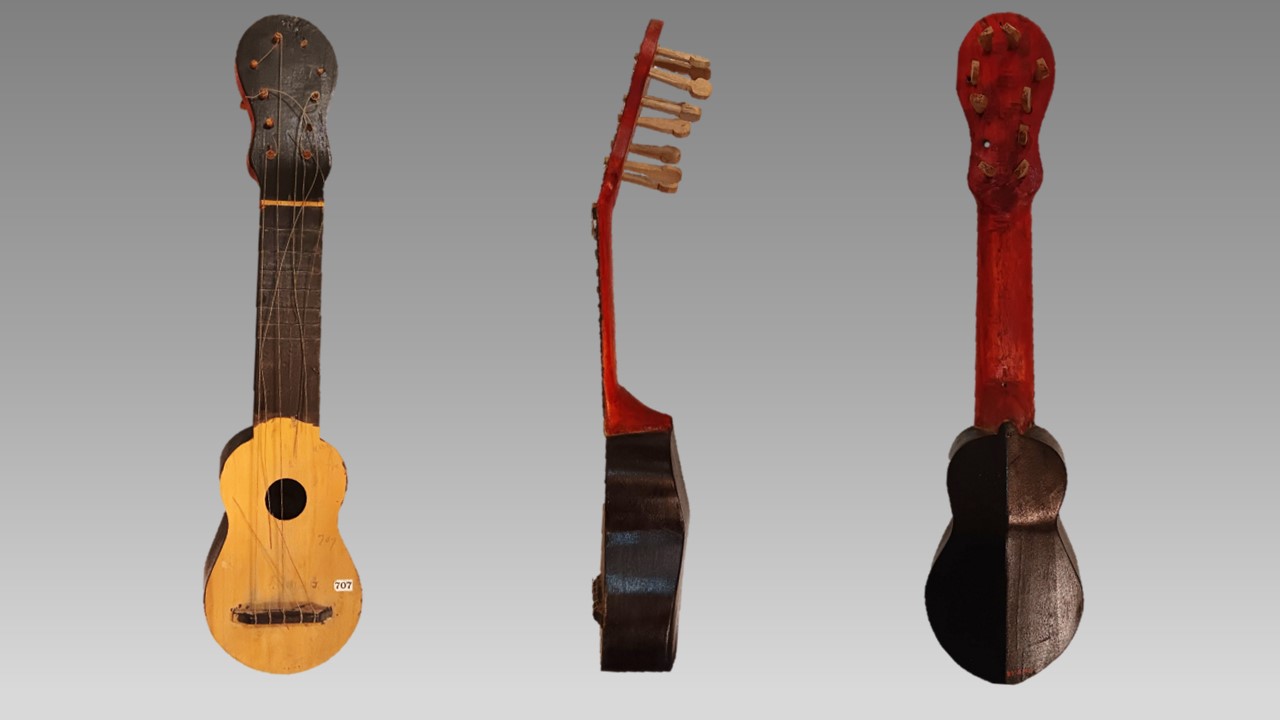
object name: tiple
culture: south american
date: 1801-1900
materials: metal, wood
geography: brazil